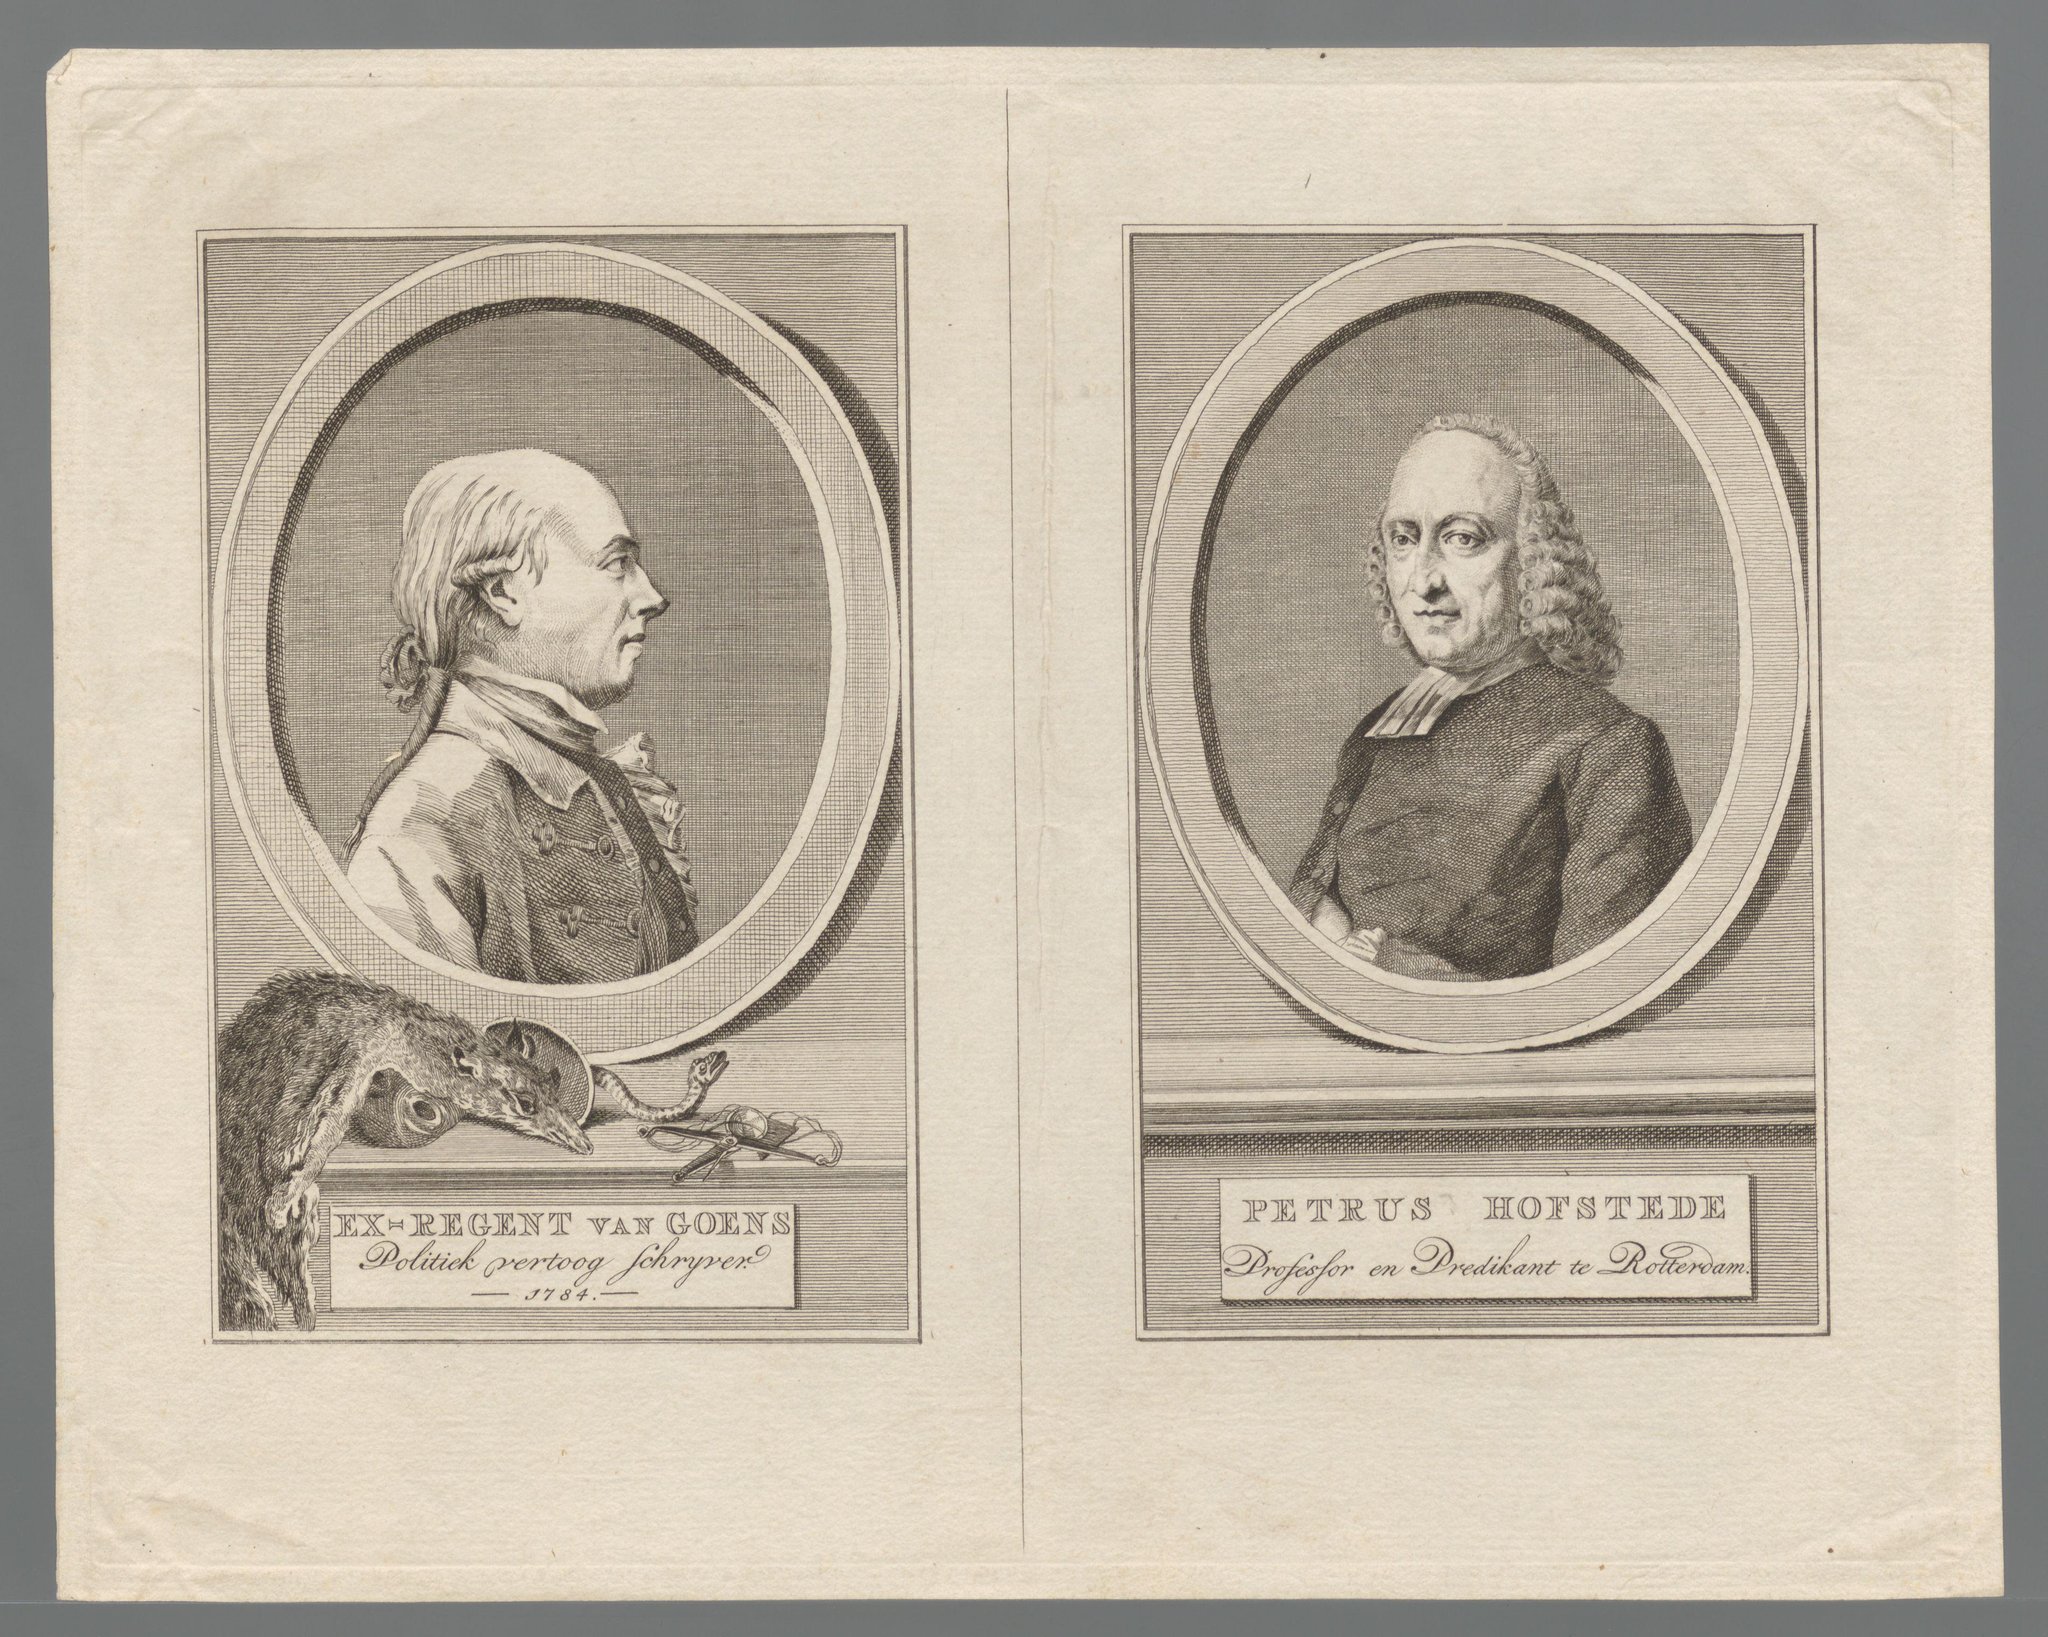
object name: print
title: Portretten van Rijklof Michael van Goes en Petrus Hofstede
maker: Anonymous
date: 1784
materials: paper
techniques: engraving, etching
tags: rotterdam, petrus hofstede, utrecht, adult man, historical persons, patriots (1780-1795)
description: Bij deze portretten een begeleidend blad met verzen getiteld: Een viertal verzen, op den alom befaamden ex-regent R.M. van Goens. Schelm voor't vaderland, en beminnaar van het Oranje huis / Een vyftal verzen, op den berugten Petrus Hofstede, schelm voor't vaderland, en beminnaar van het Oranje huis. S.l.s.n. [1782]. De portretten zijn door Muller beschreven bij het jaar 1784.